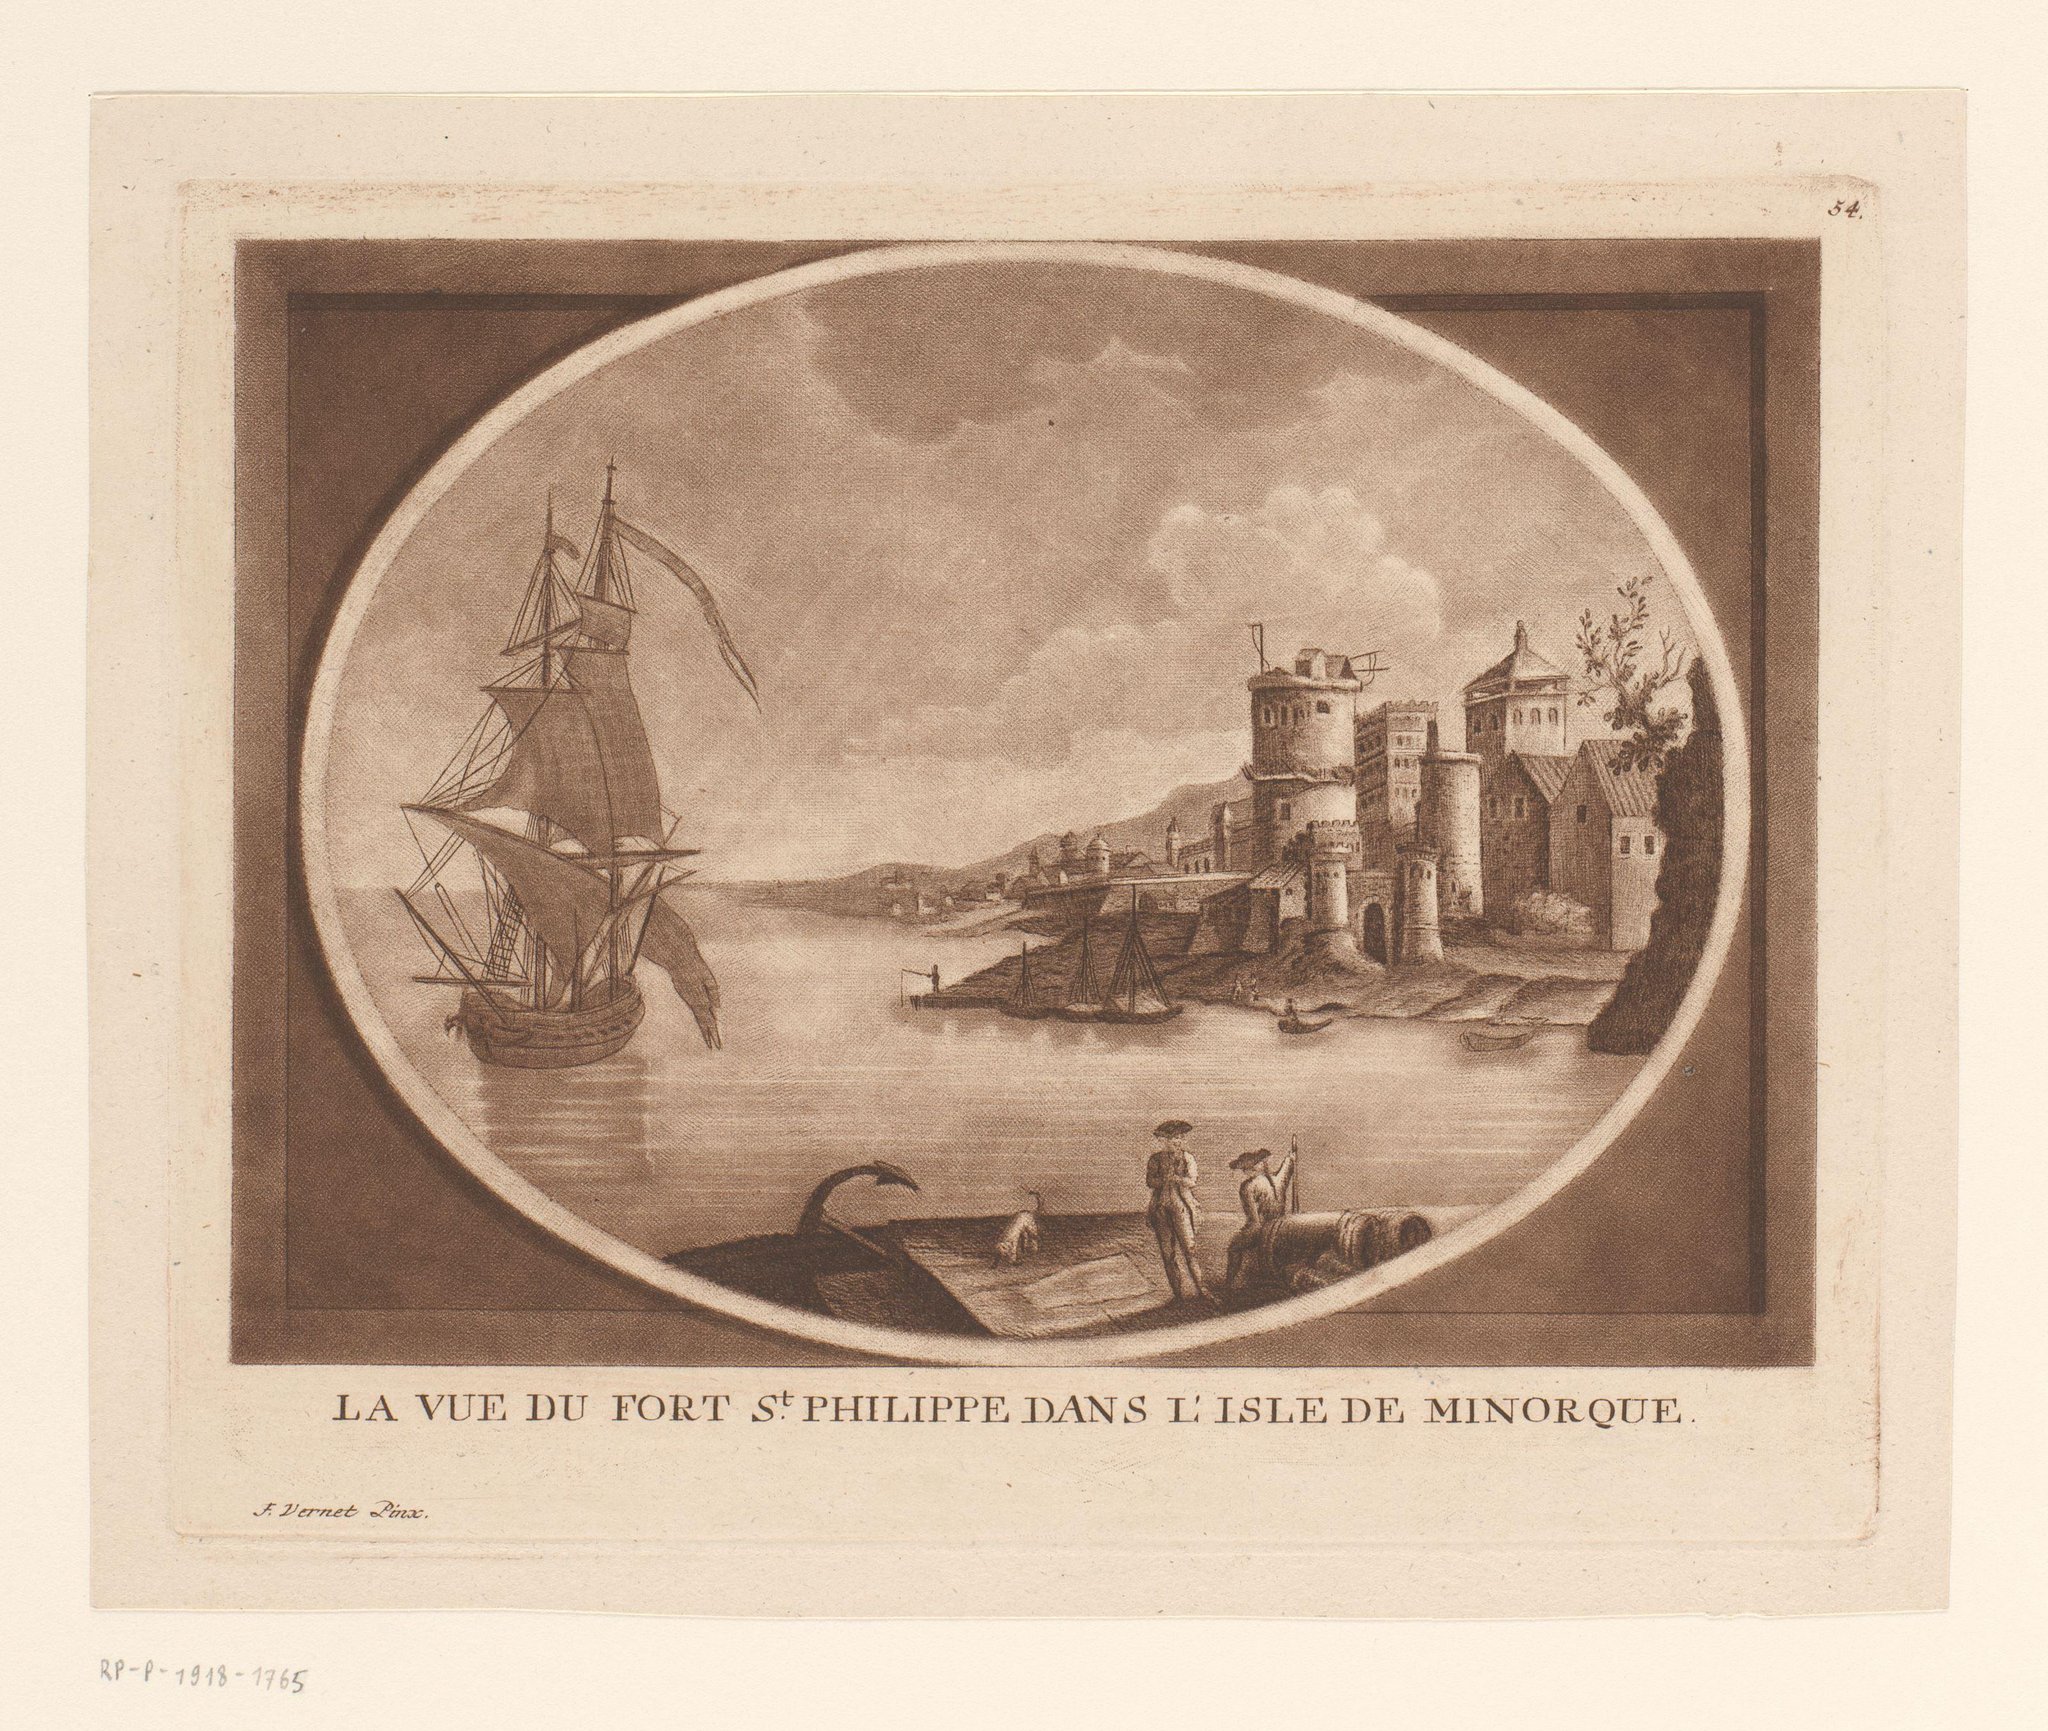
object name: print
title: La vue du fort St. Philippe dans l'isle de Minorque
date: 1740-1800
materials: paper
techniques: aquatint, etching, roulette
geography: france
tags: harbour, fortress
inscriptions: collector's mark: Lugt 2233